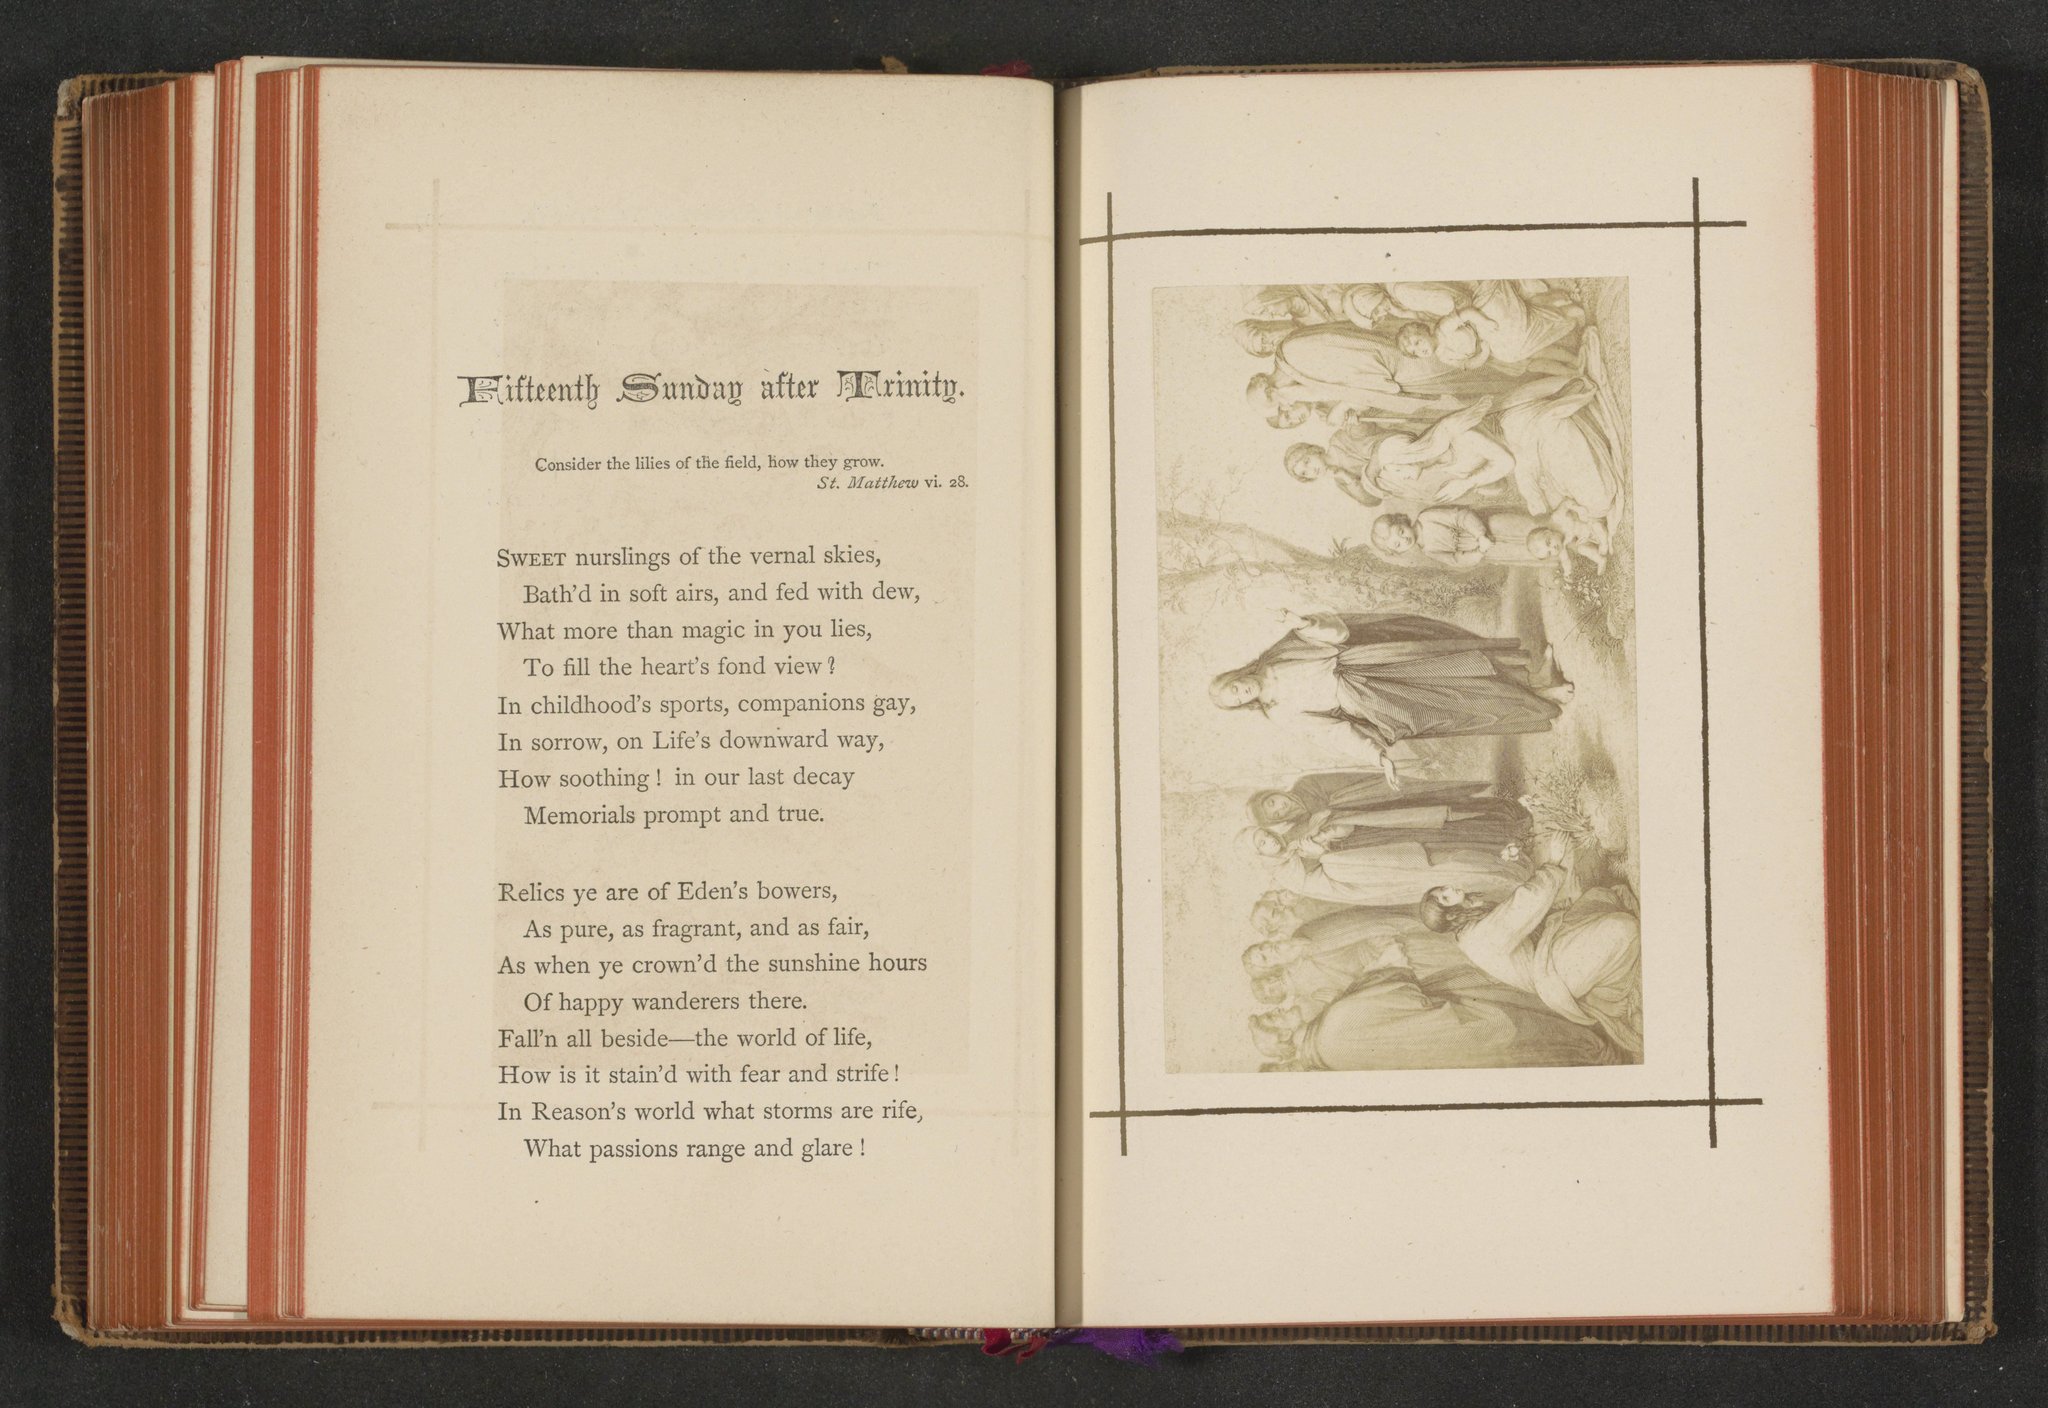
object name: page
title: Fotoreproductie van een prent, voorstellende Christus toont zijn volgelingen lelies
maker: Anonymous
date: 1865-1870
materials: photographic support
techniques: albumen print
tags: 'consider the lilies of the field' ~ doctrine of christ on anxiety and precaution (matthew 6:28; luke 12:27)